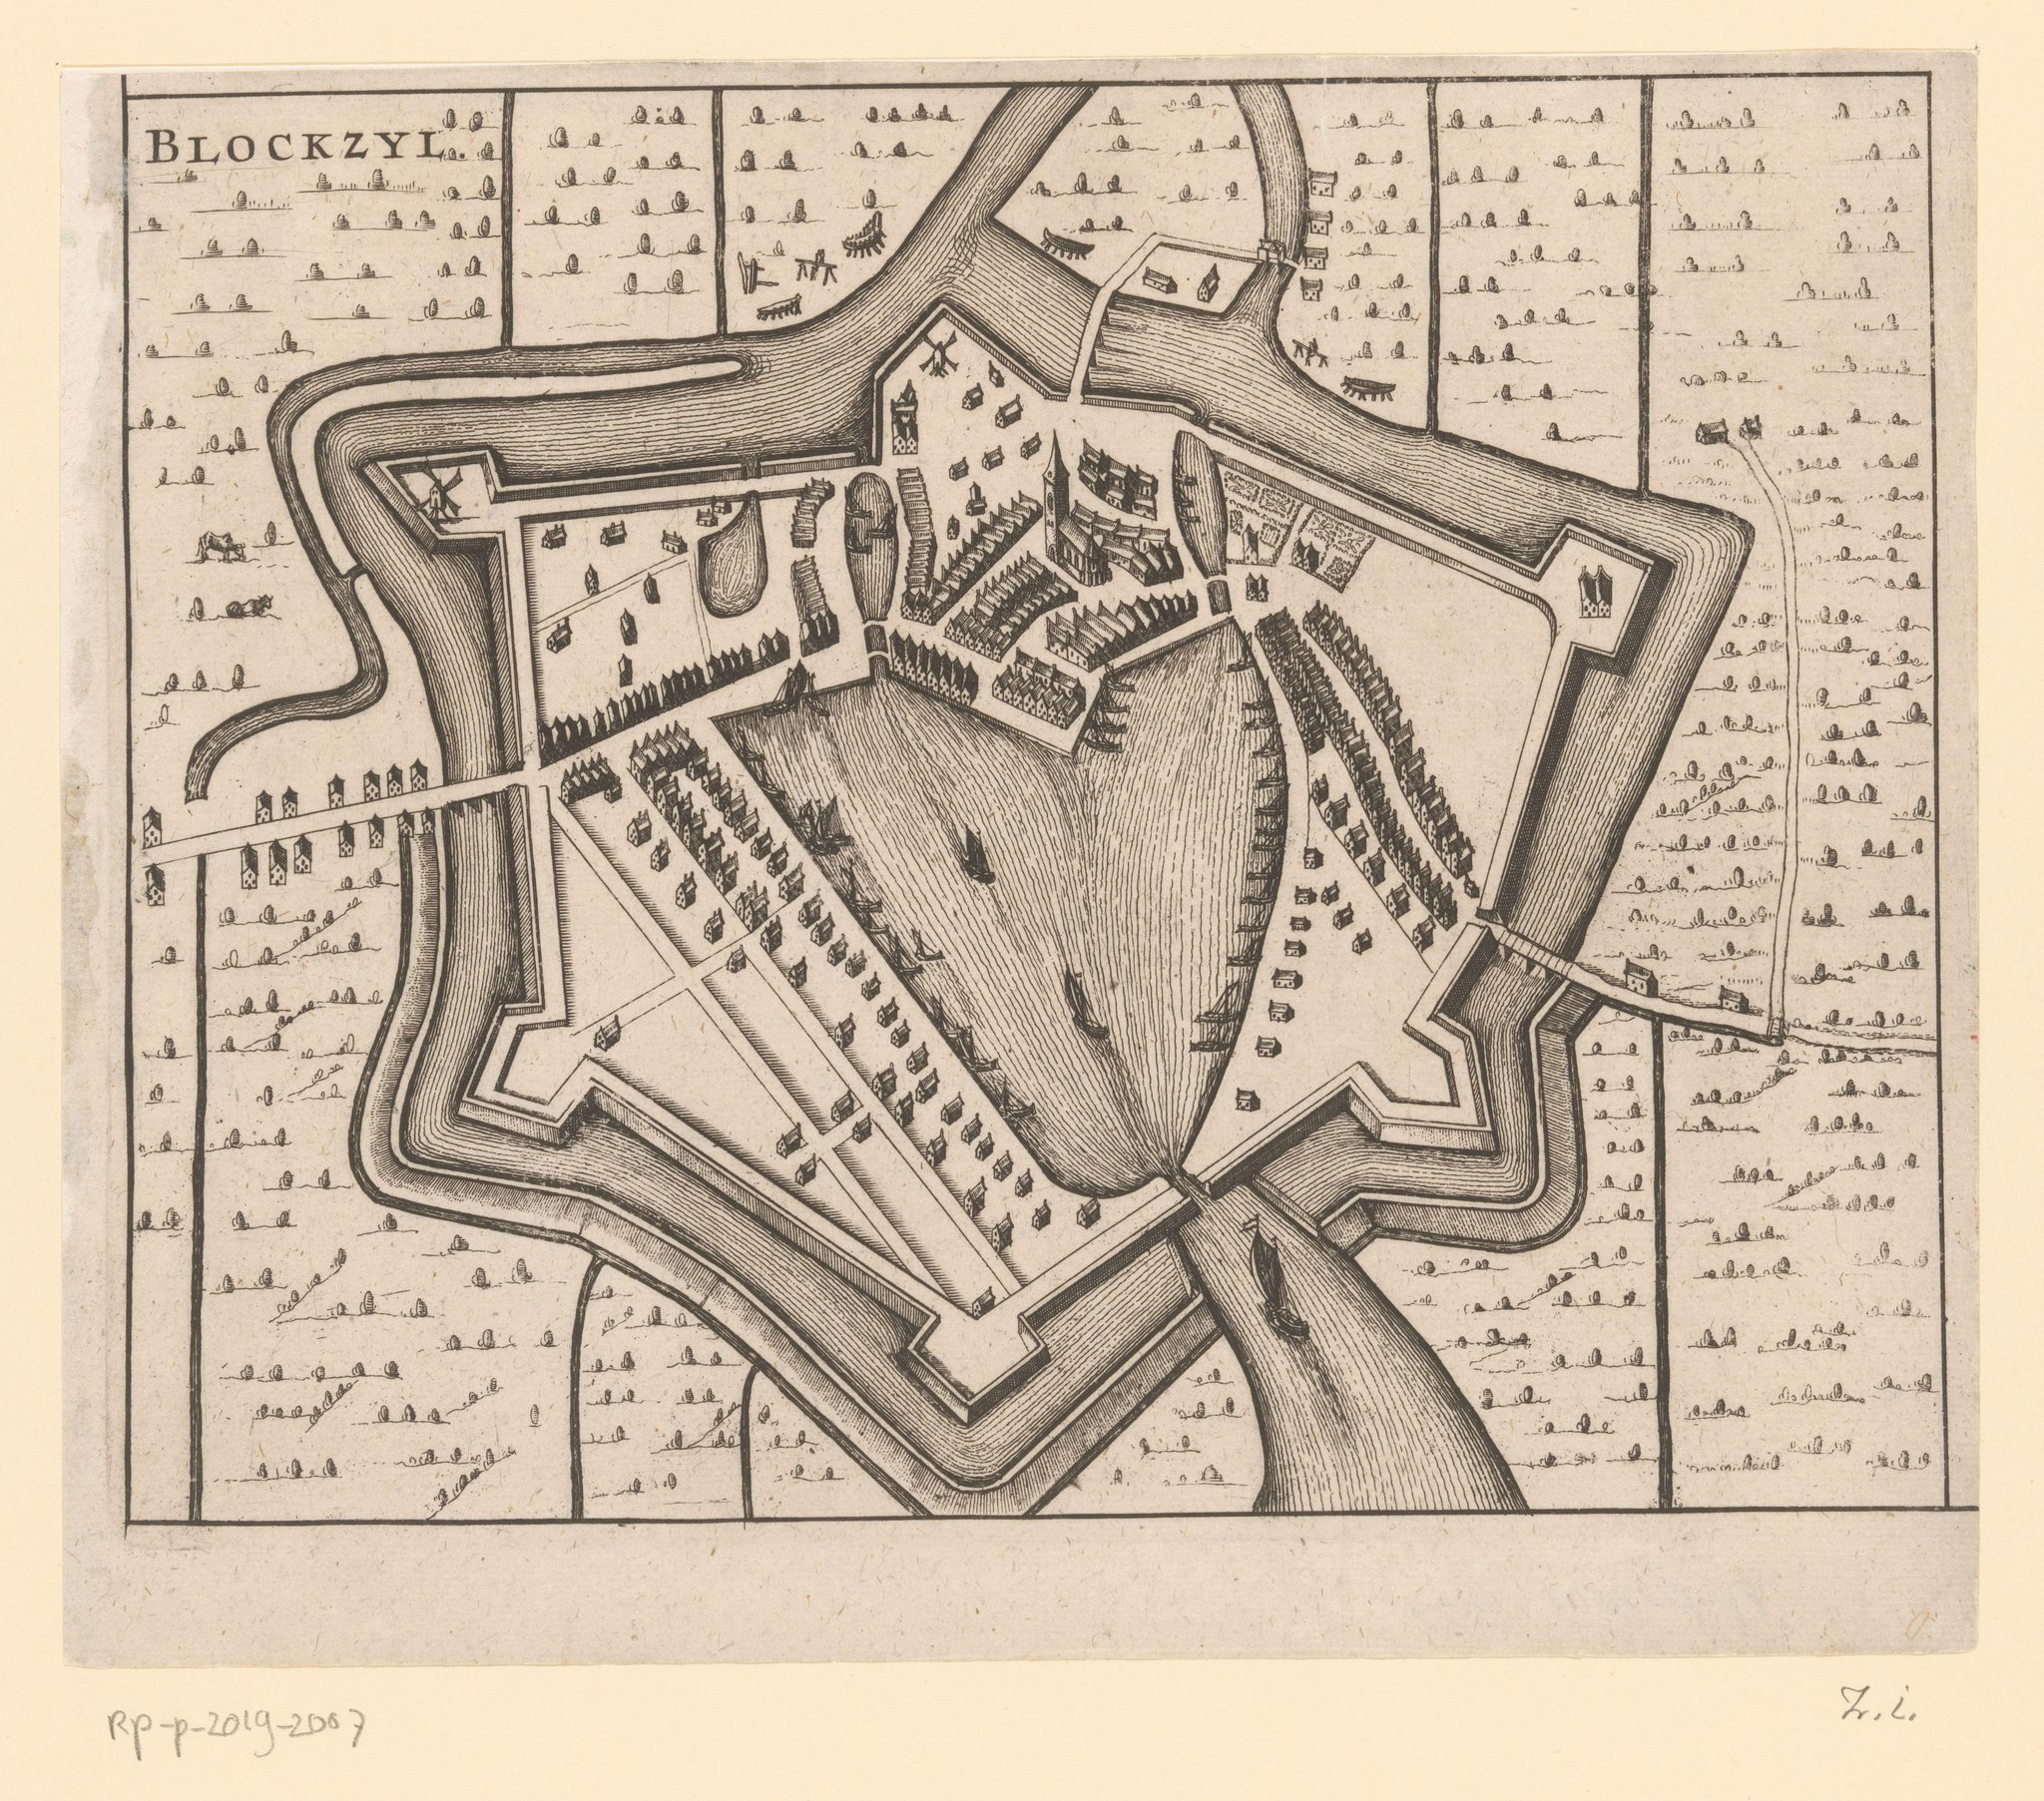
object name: area plan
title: Blockzyl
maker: Anonymous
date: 1650-1700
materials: paper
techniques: etching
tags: fortified city, maps of cities